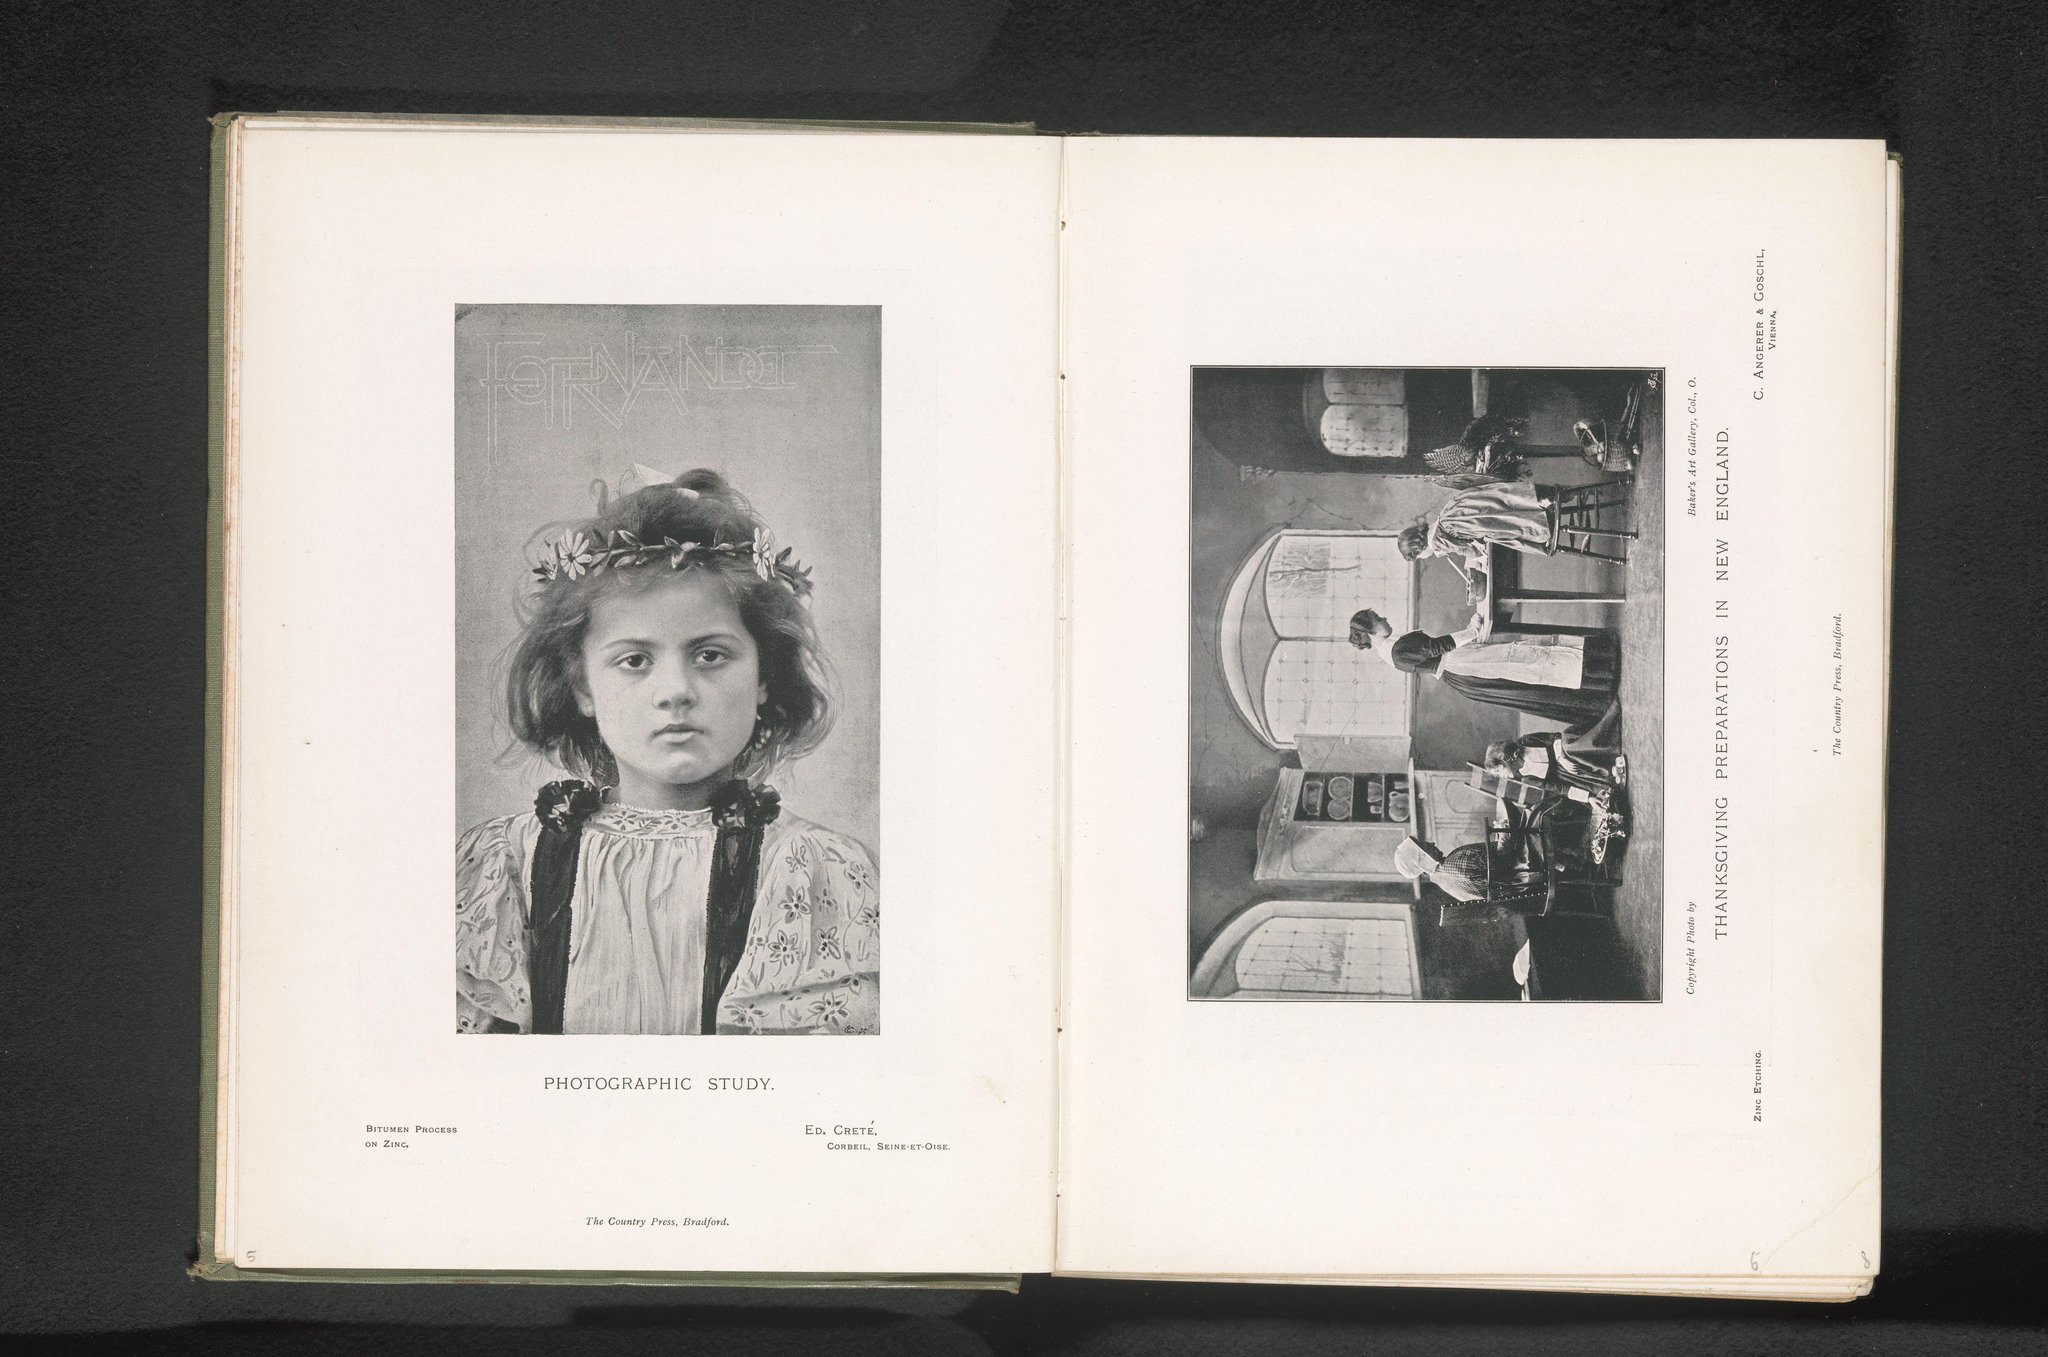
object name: page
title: Portret van een onbekend meisje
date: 1893-1898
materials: paper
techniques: autotype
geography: corbeil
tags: historical persons - bb - woman, girl (child between toddler and youth)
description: Prent op tweede ongenummerde pagina na pagina 4.